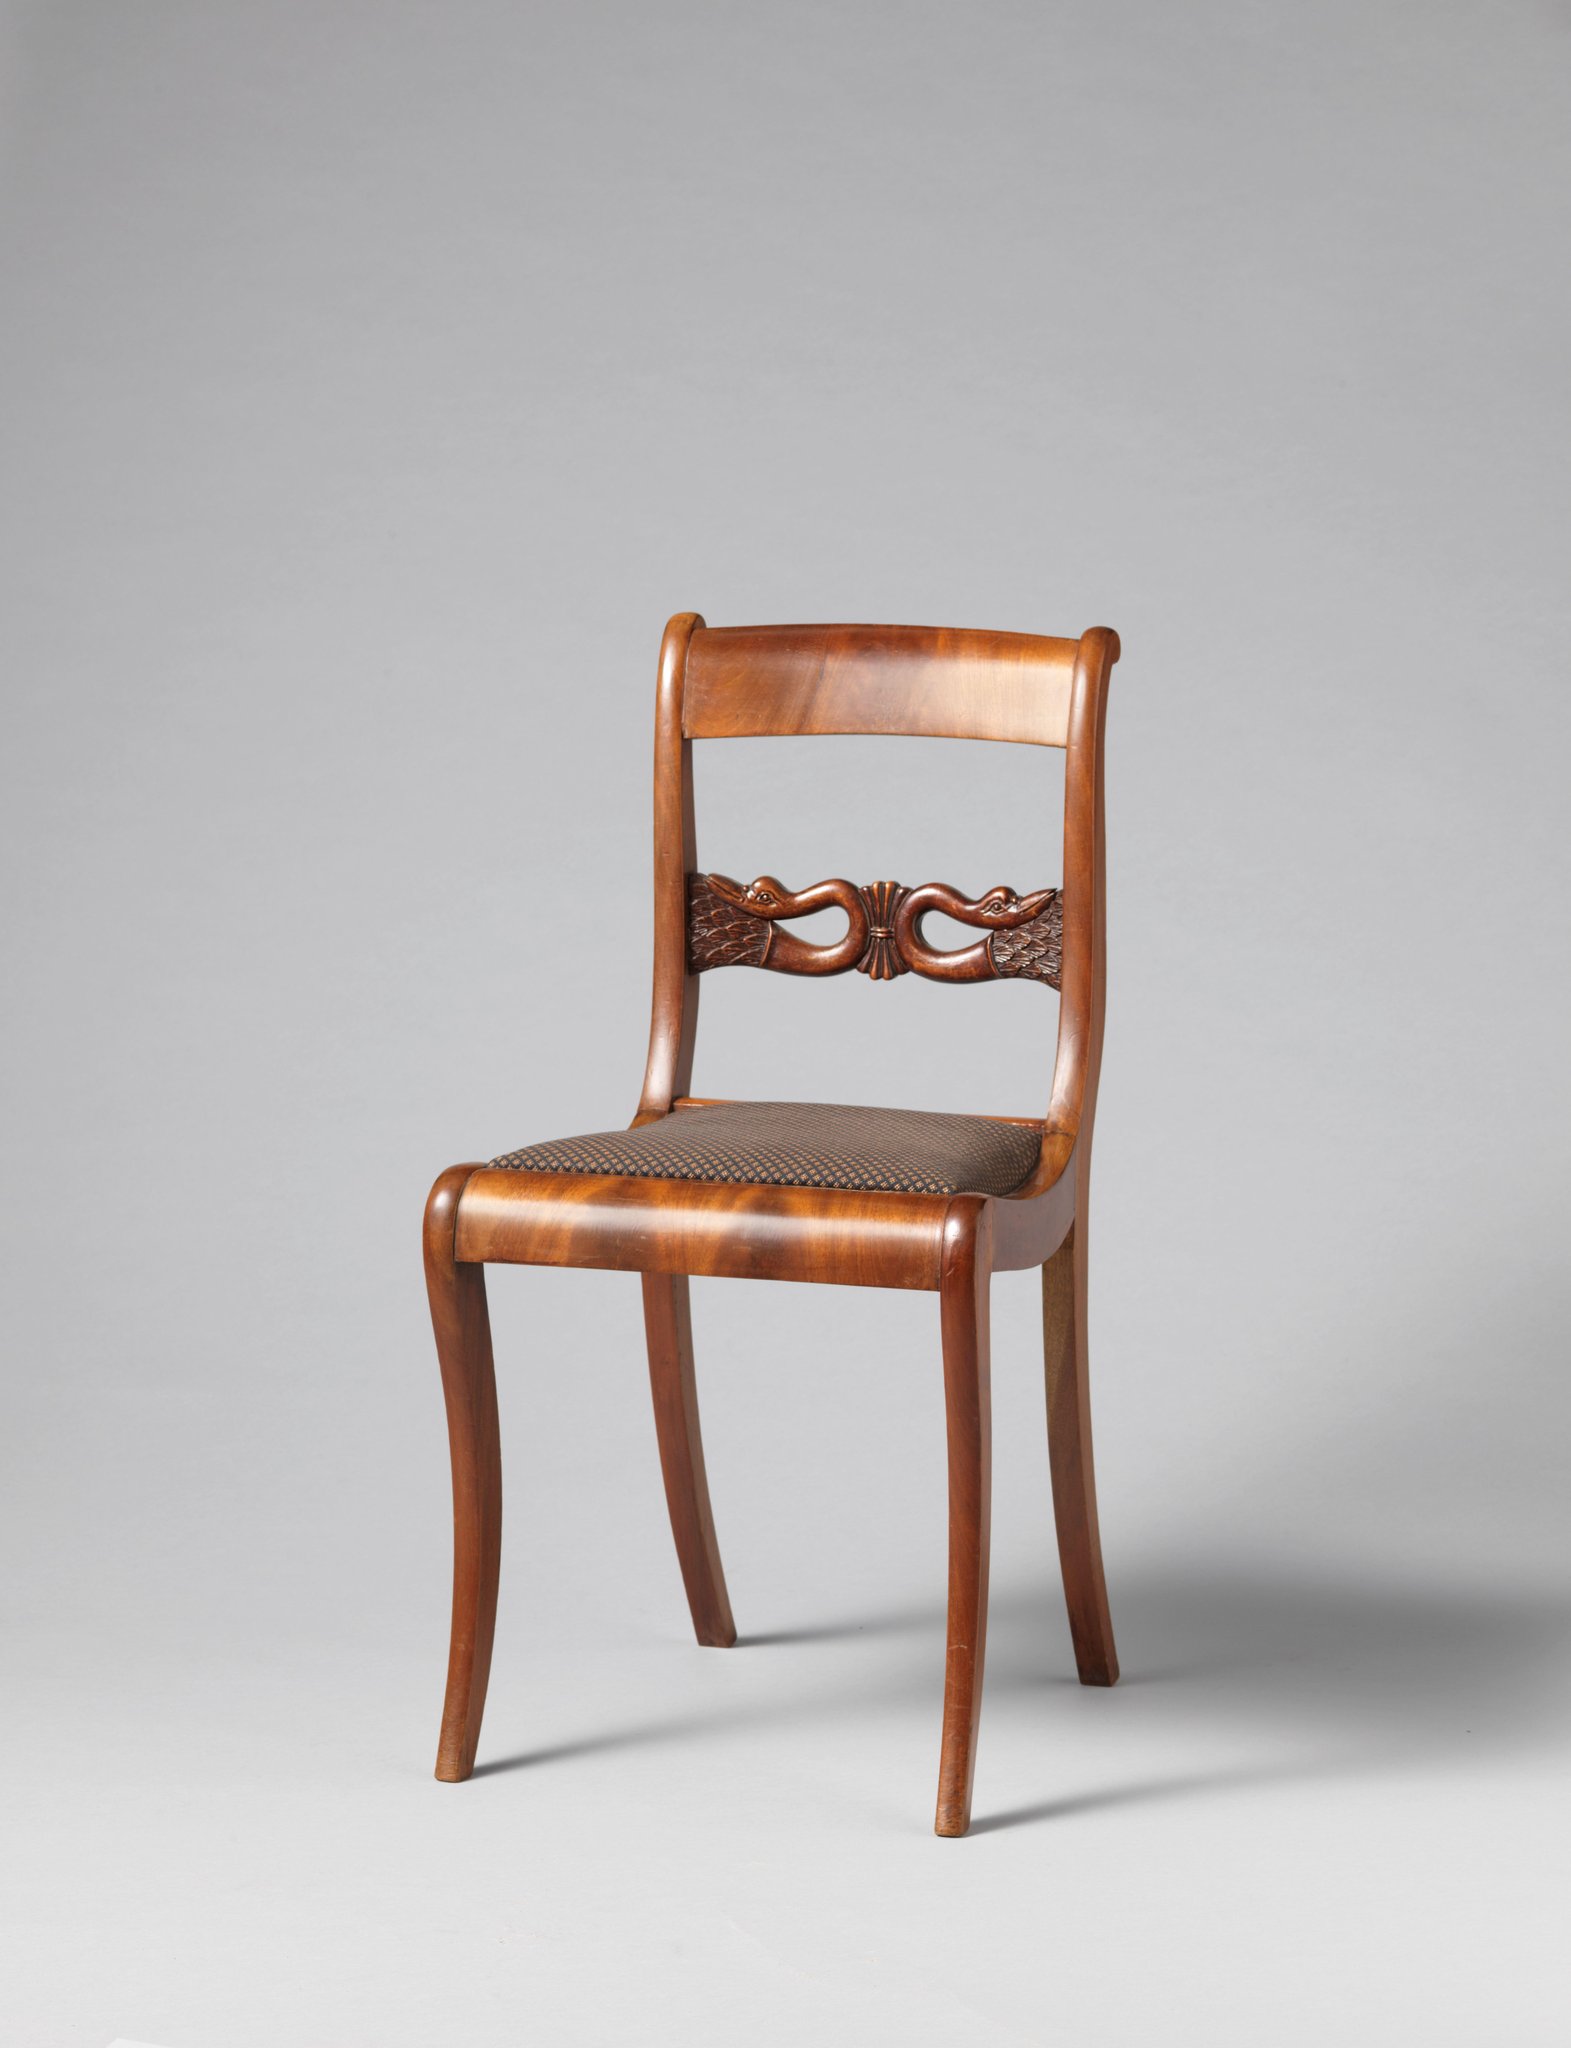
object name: seating furniture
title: Stoel met zwanen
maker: Anonymous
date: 1830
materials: wood, textile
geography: northern netherlands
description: Stoel uit een set van tien stoelen en vier armstoelen van deels massief en deels belijmd mahoniehout op iepenhouten kern. Losse beklede zittingen. De vierkante achterpoten wijken achterwaarts. Negen stoelen en een armstoel hebben vierkante, aan de voorzijde iets afgeronde, voorpoten; de rest heeft ronde gelede voorpoten. De gestrekt S-vormige ruggen hebben een gebeeldhouwde tussenregel met een palmet geflankeerd door twee toegewende, met de halzen terugbuigende zwanen. De platte voluutvormige armleggers lopen hoog in de rug over.